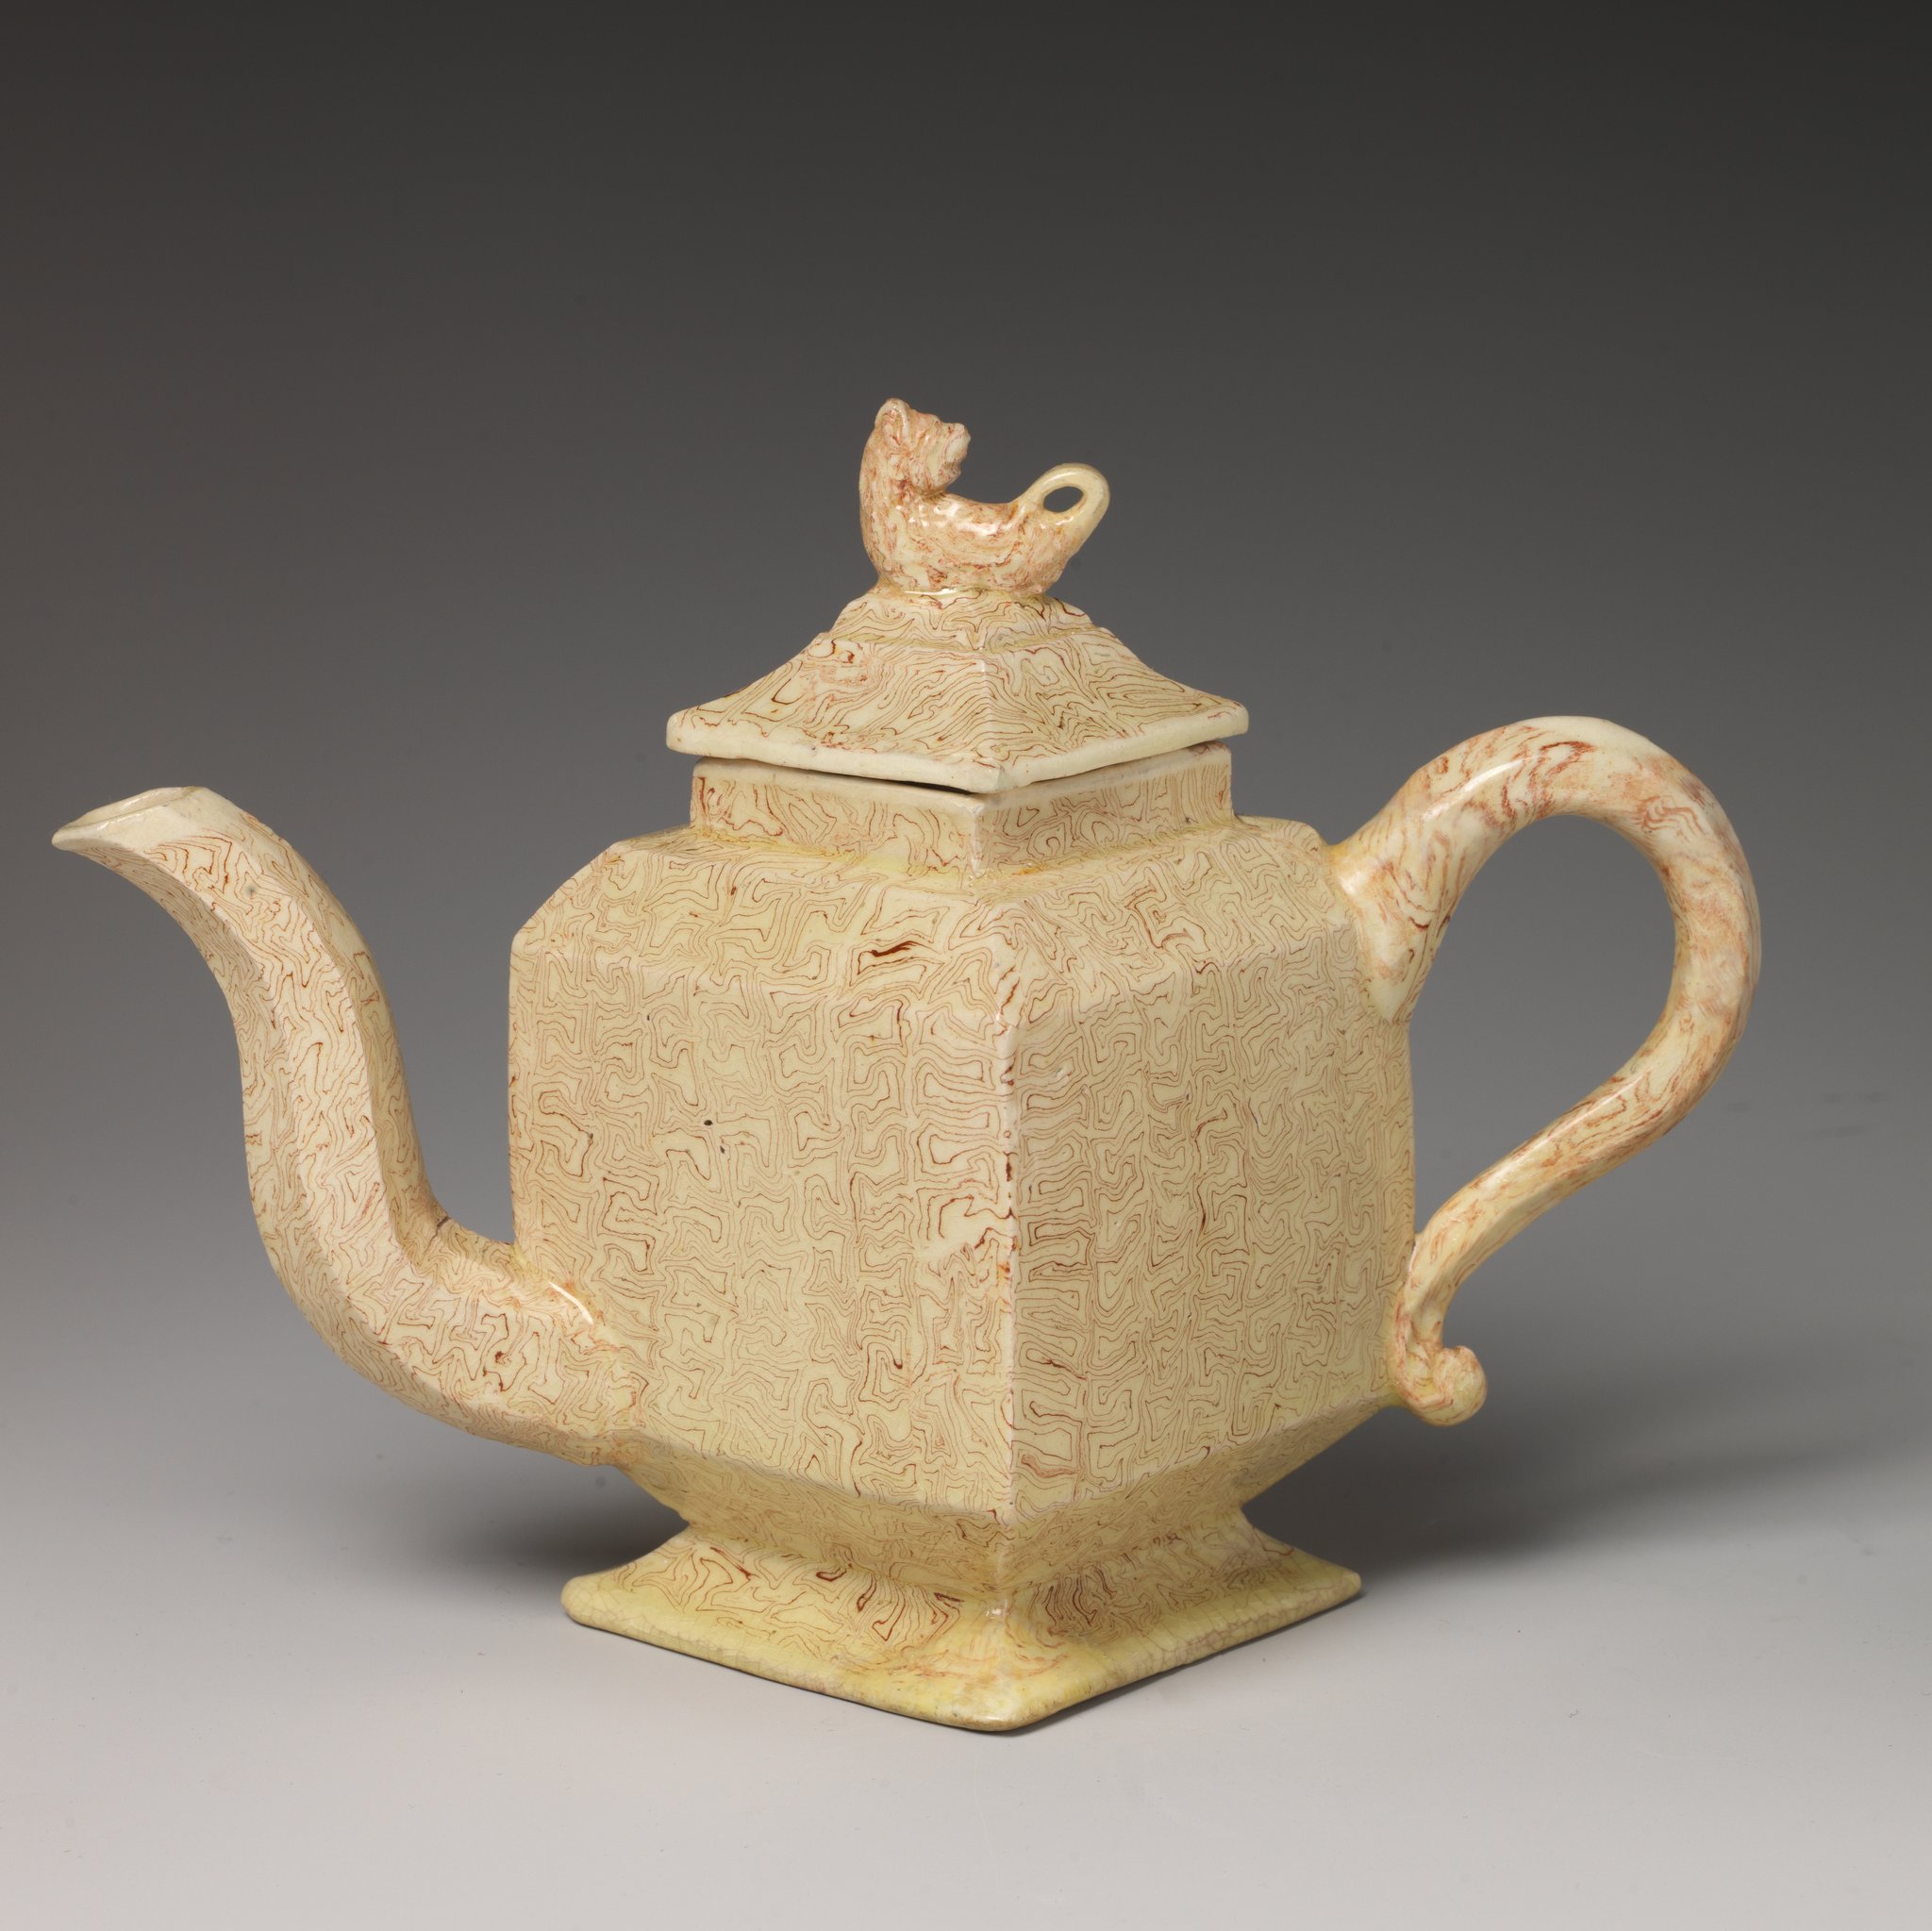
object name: teapot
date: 1750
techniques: glazing